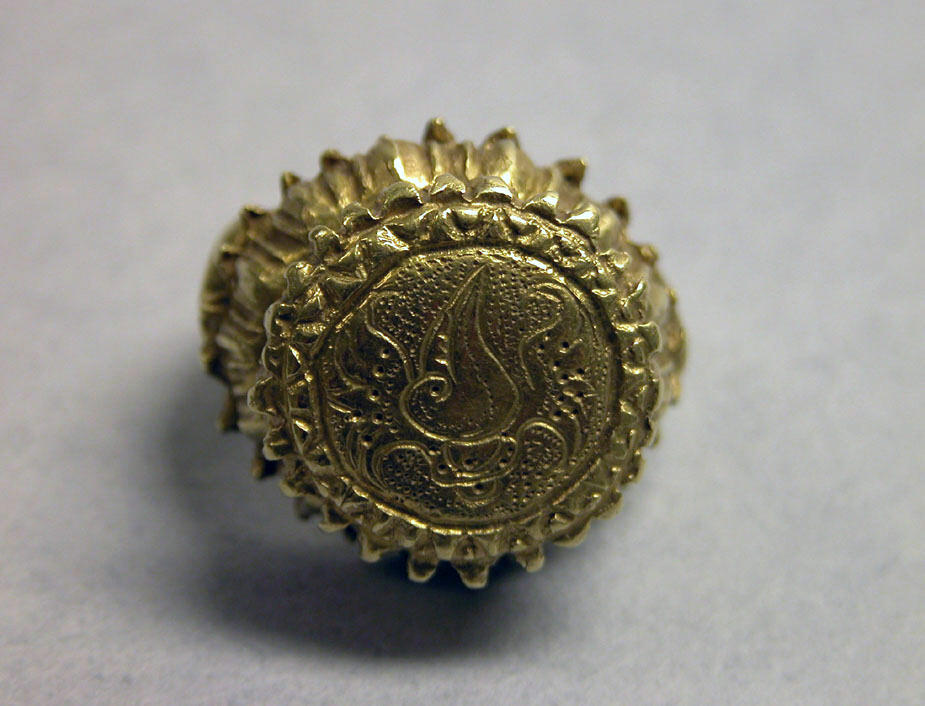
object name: ring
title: Stirrup-shaped Ring with Circular Bezel with Inscribed "Shankha"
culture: indonesian, javanese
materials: gold